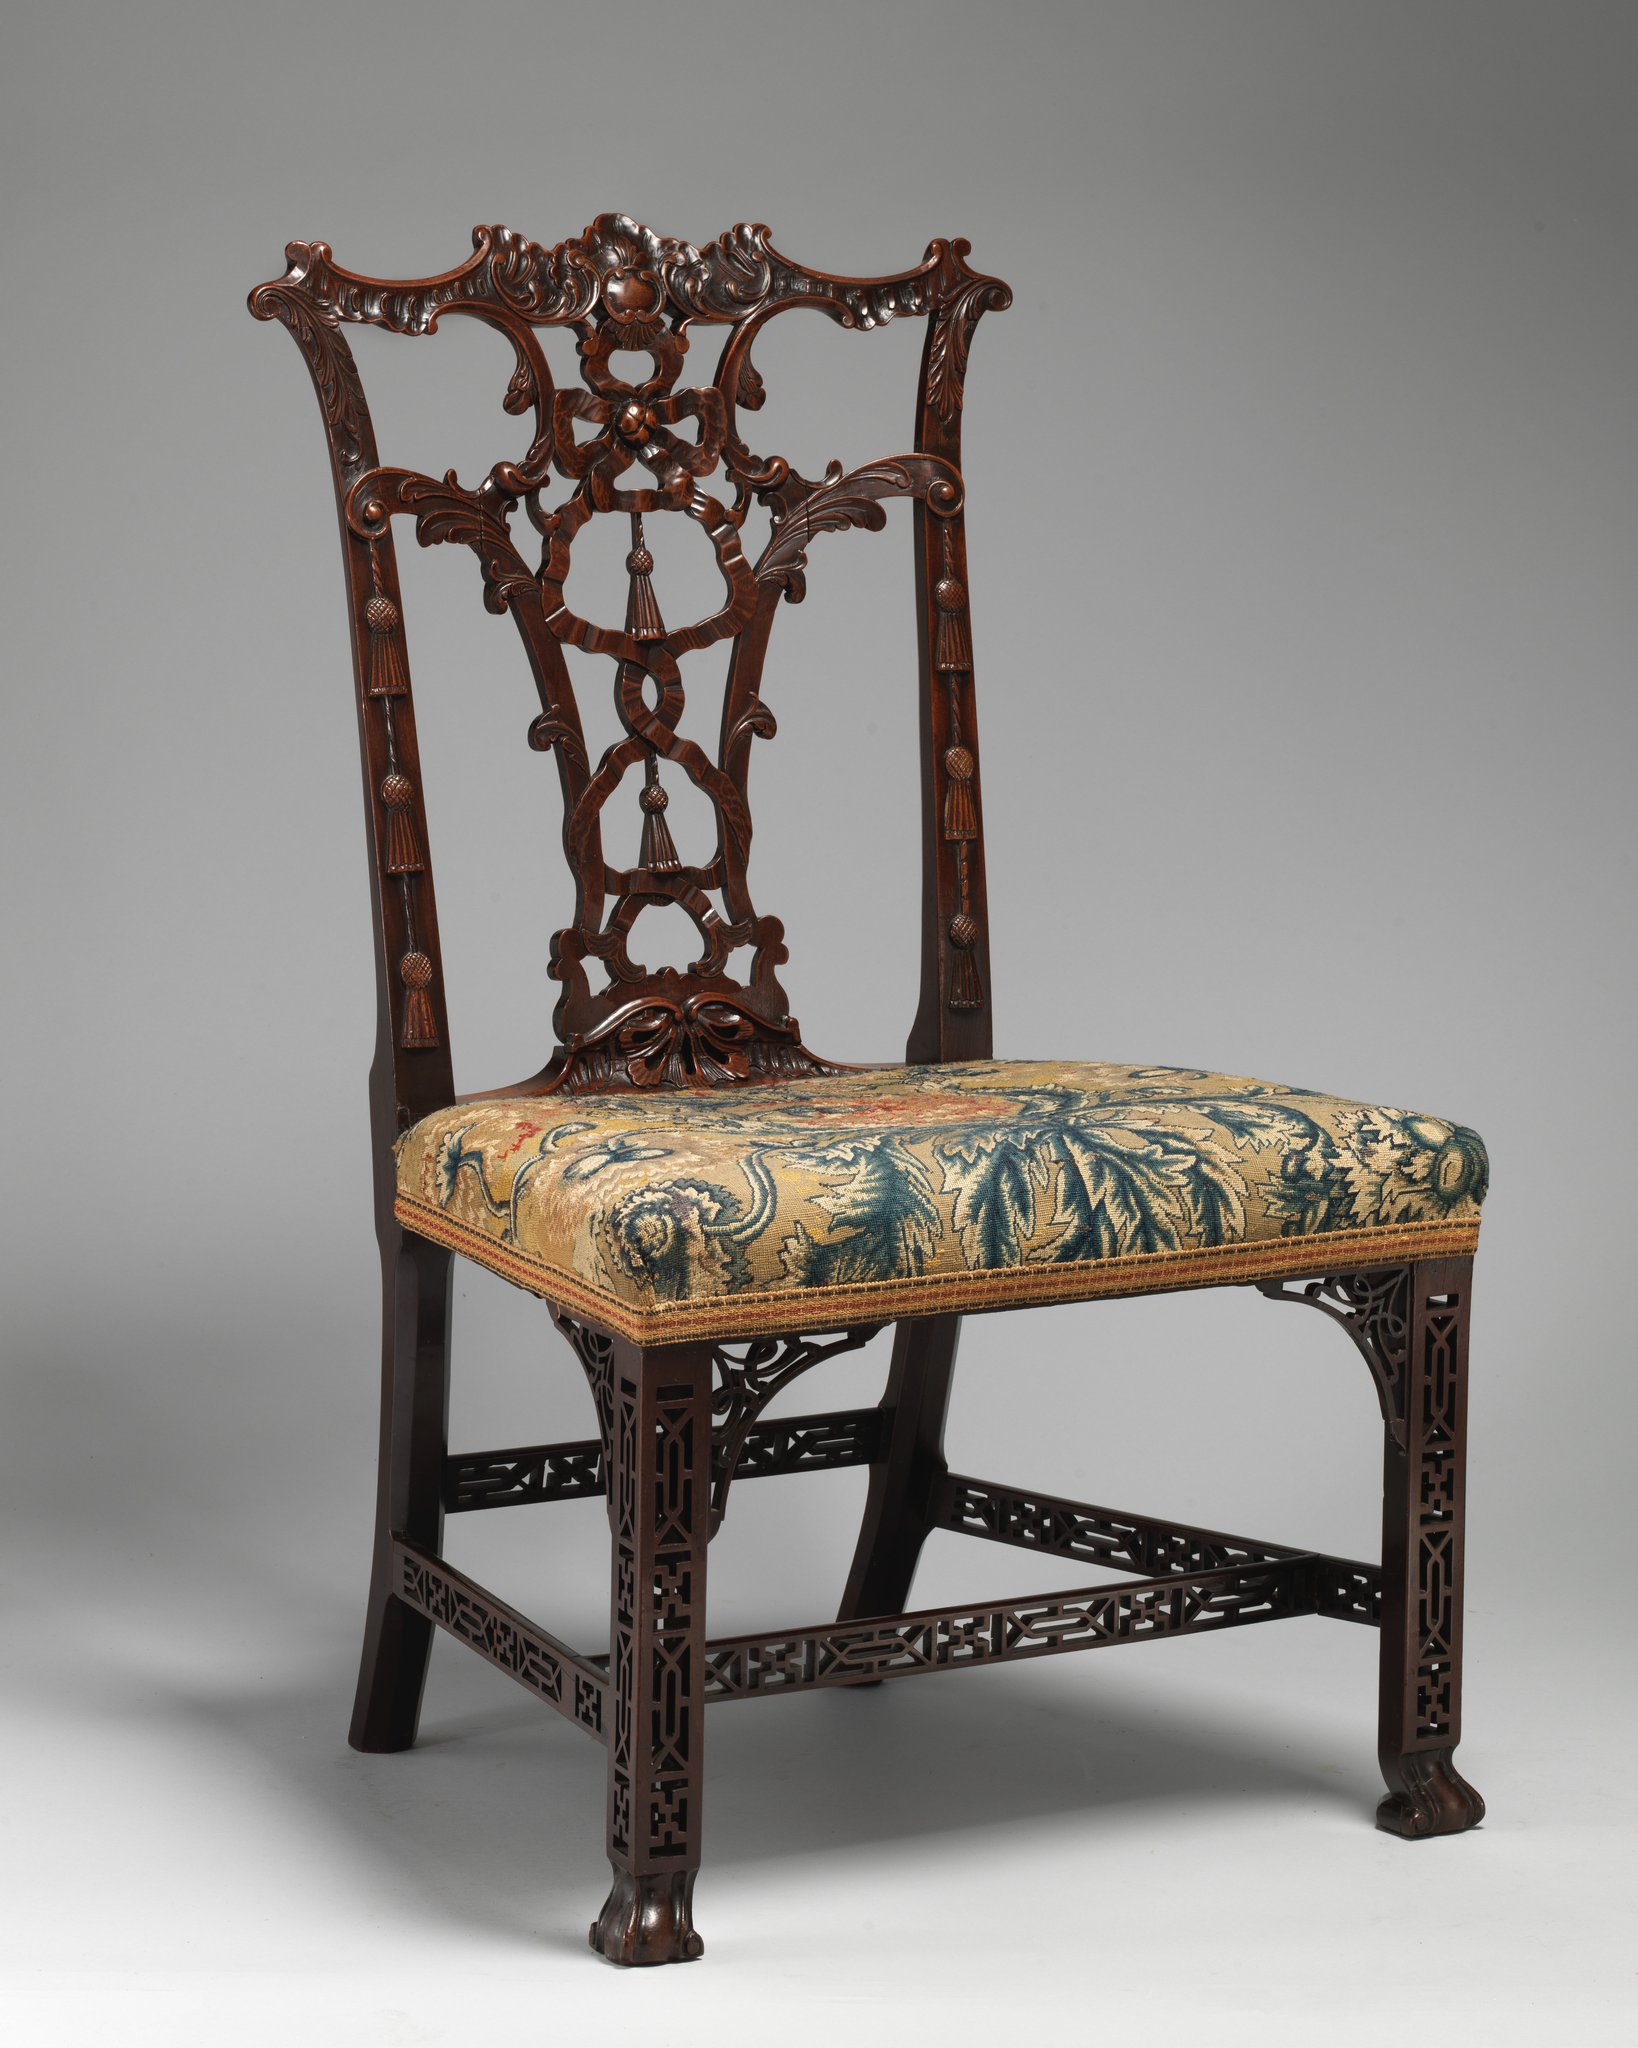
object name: side chair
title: Side chair (one of a pair)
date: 1755-1760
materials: canvas, wood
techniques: embroidery, stitching